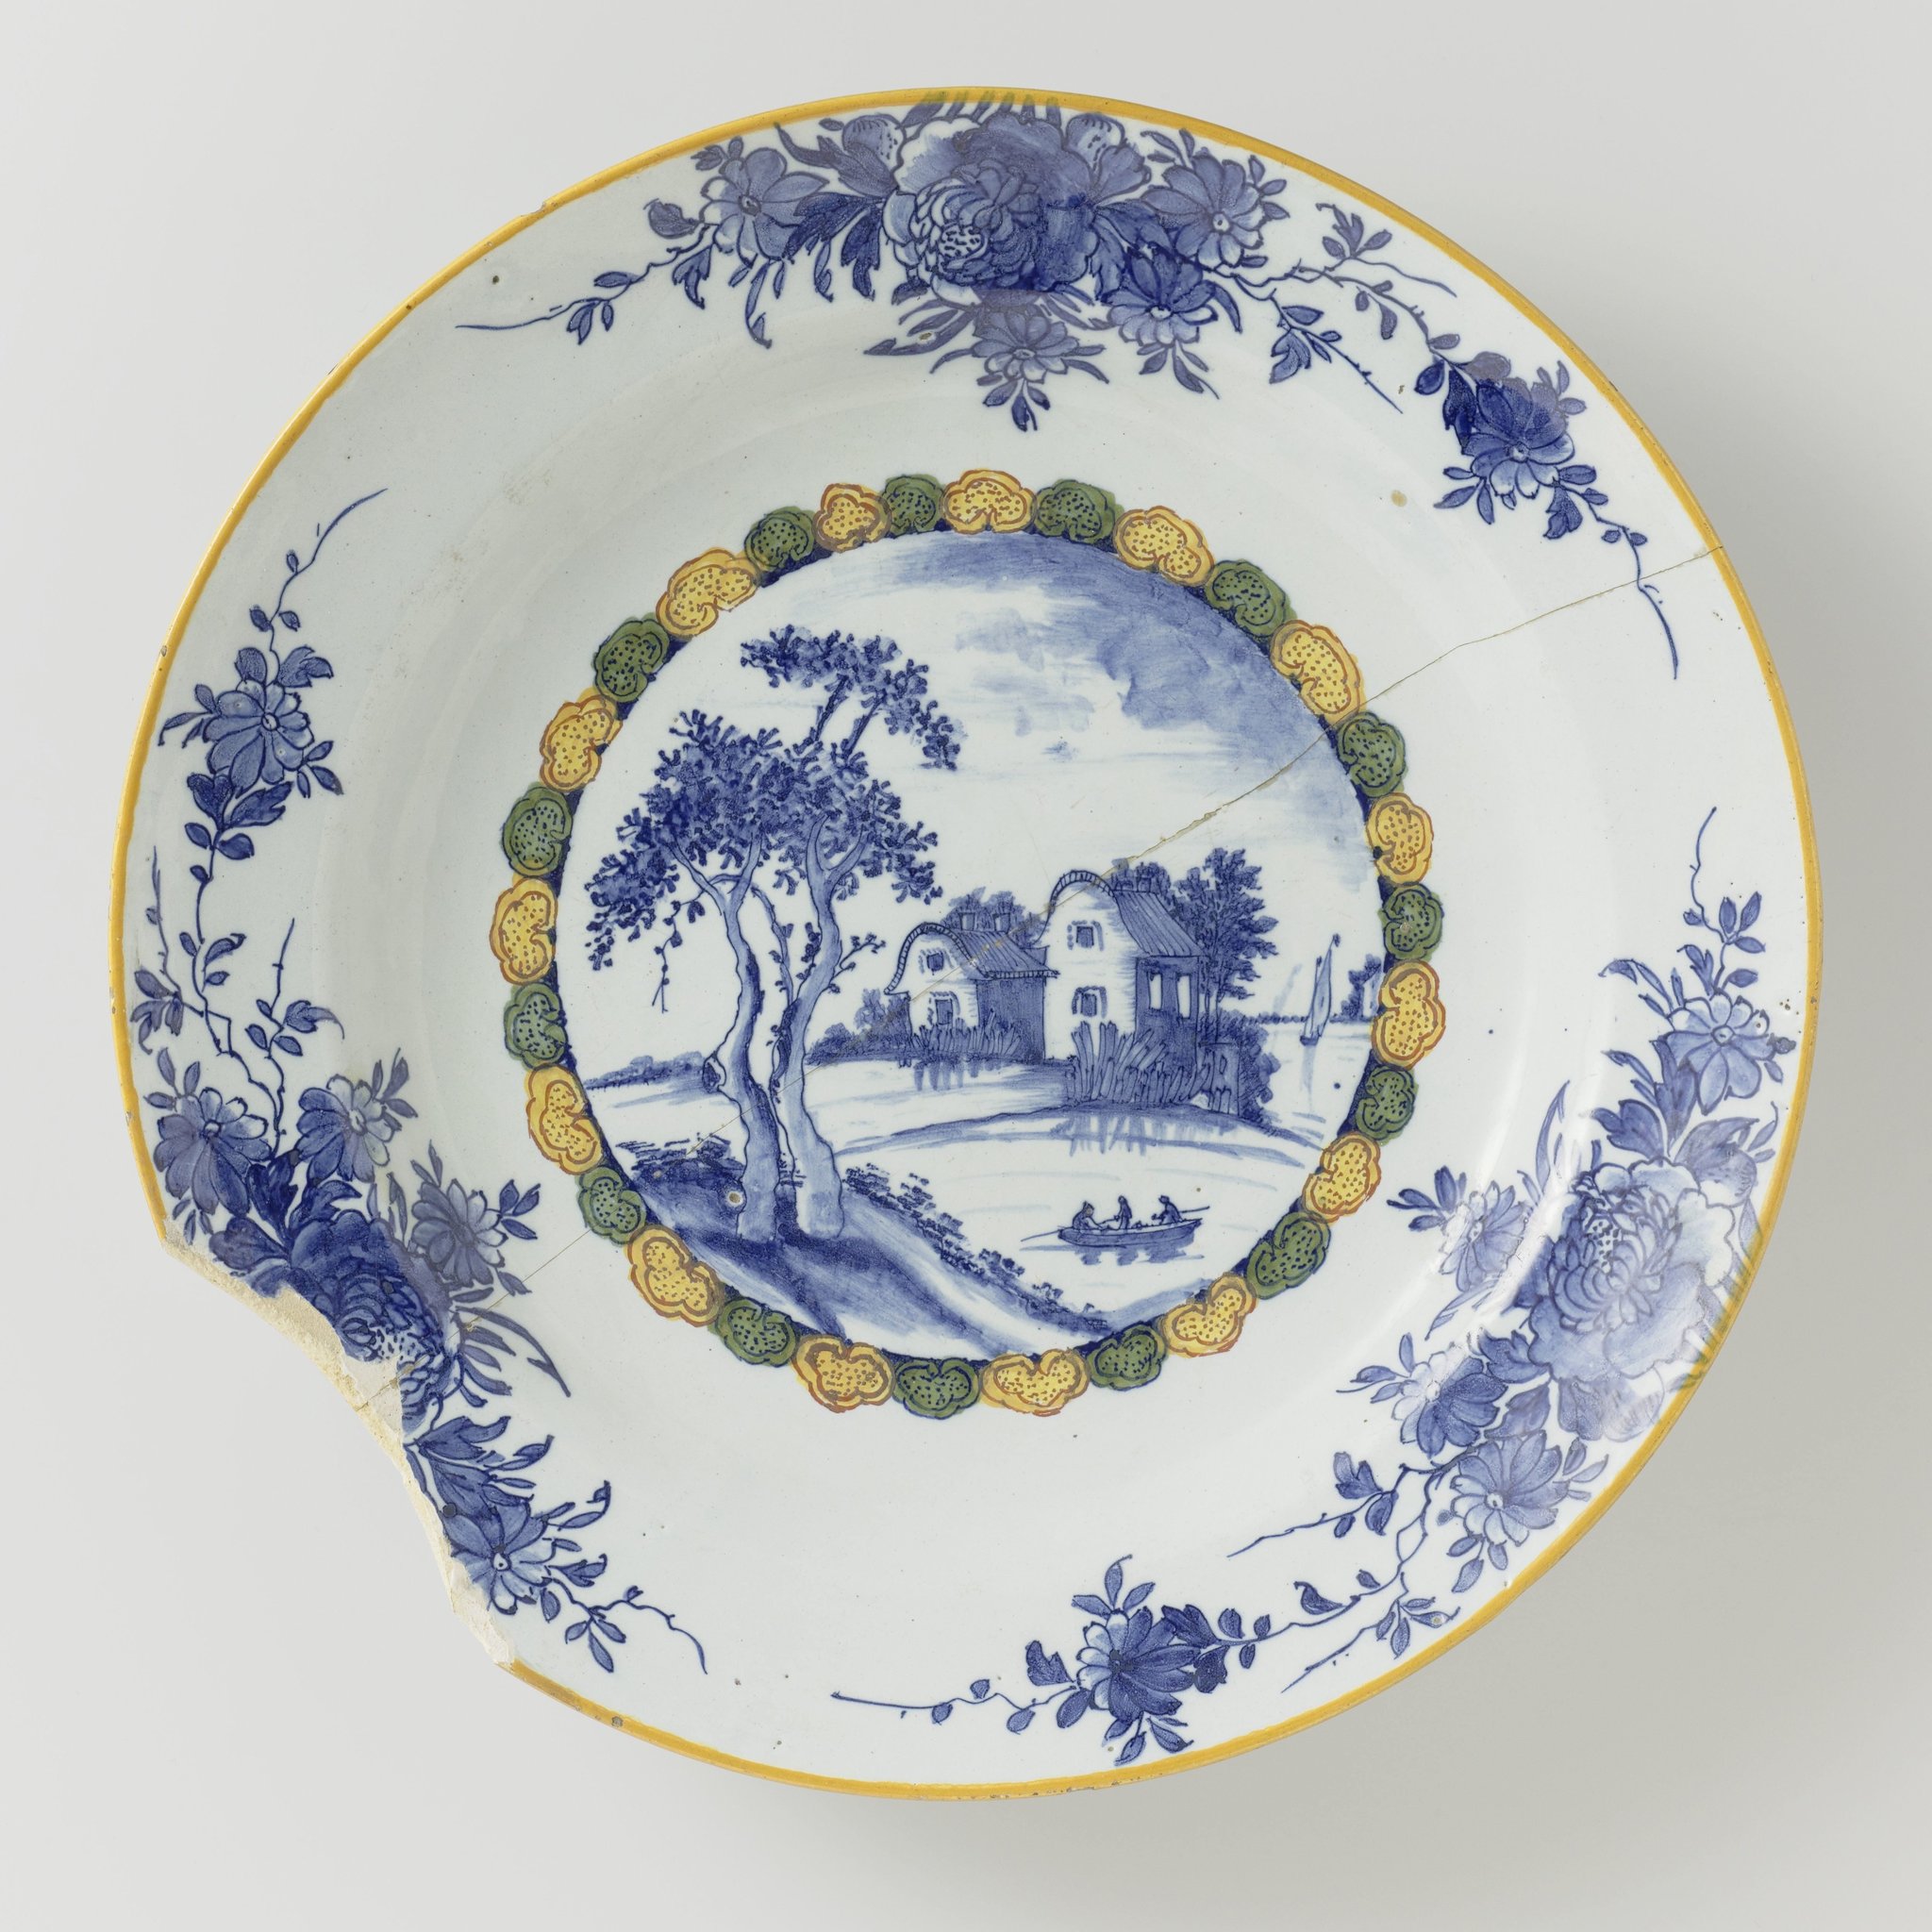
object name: platter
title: Schotel van faïence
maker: Anonymous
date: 1750-1780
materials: faience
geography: delft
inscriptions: collector's mark: ‘collection J.F. Loudon’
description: Veelkleurig beschilderd met op het plat een landschap in blauw.